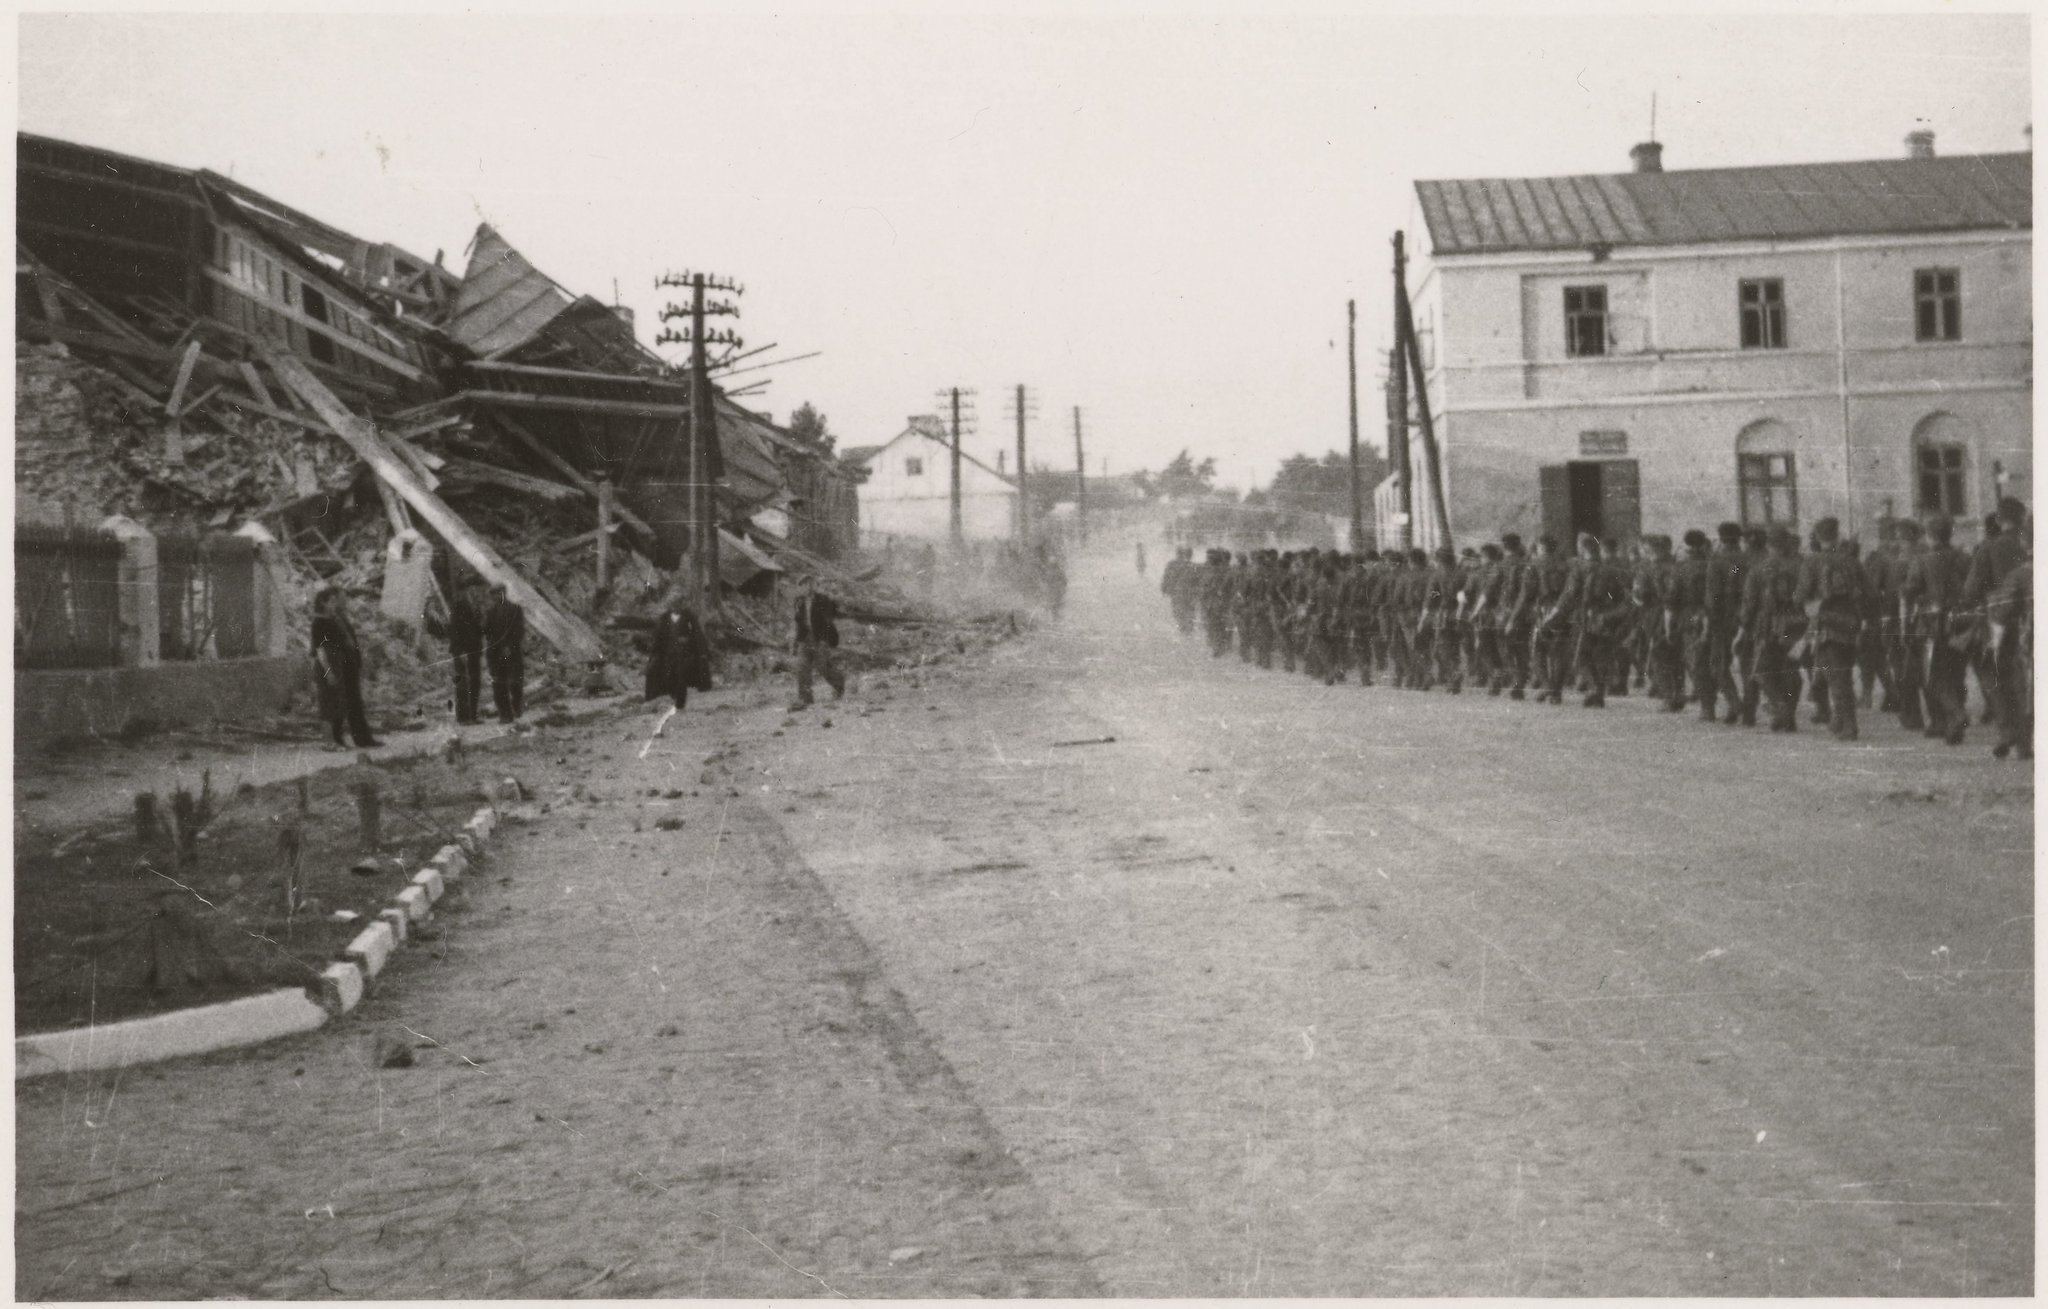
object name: photograph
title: Soldaten lopen door een kapotte stad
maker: Anonymous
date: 1940-1945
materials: photographic support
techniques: gelatin silver print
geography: czechoslovakia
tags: germany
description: Groep soldaten loopt door een kapotte stad. Links staan wat burgers. Foto behorend bij album 'Kriegserinnerungen'.